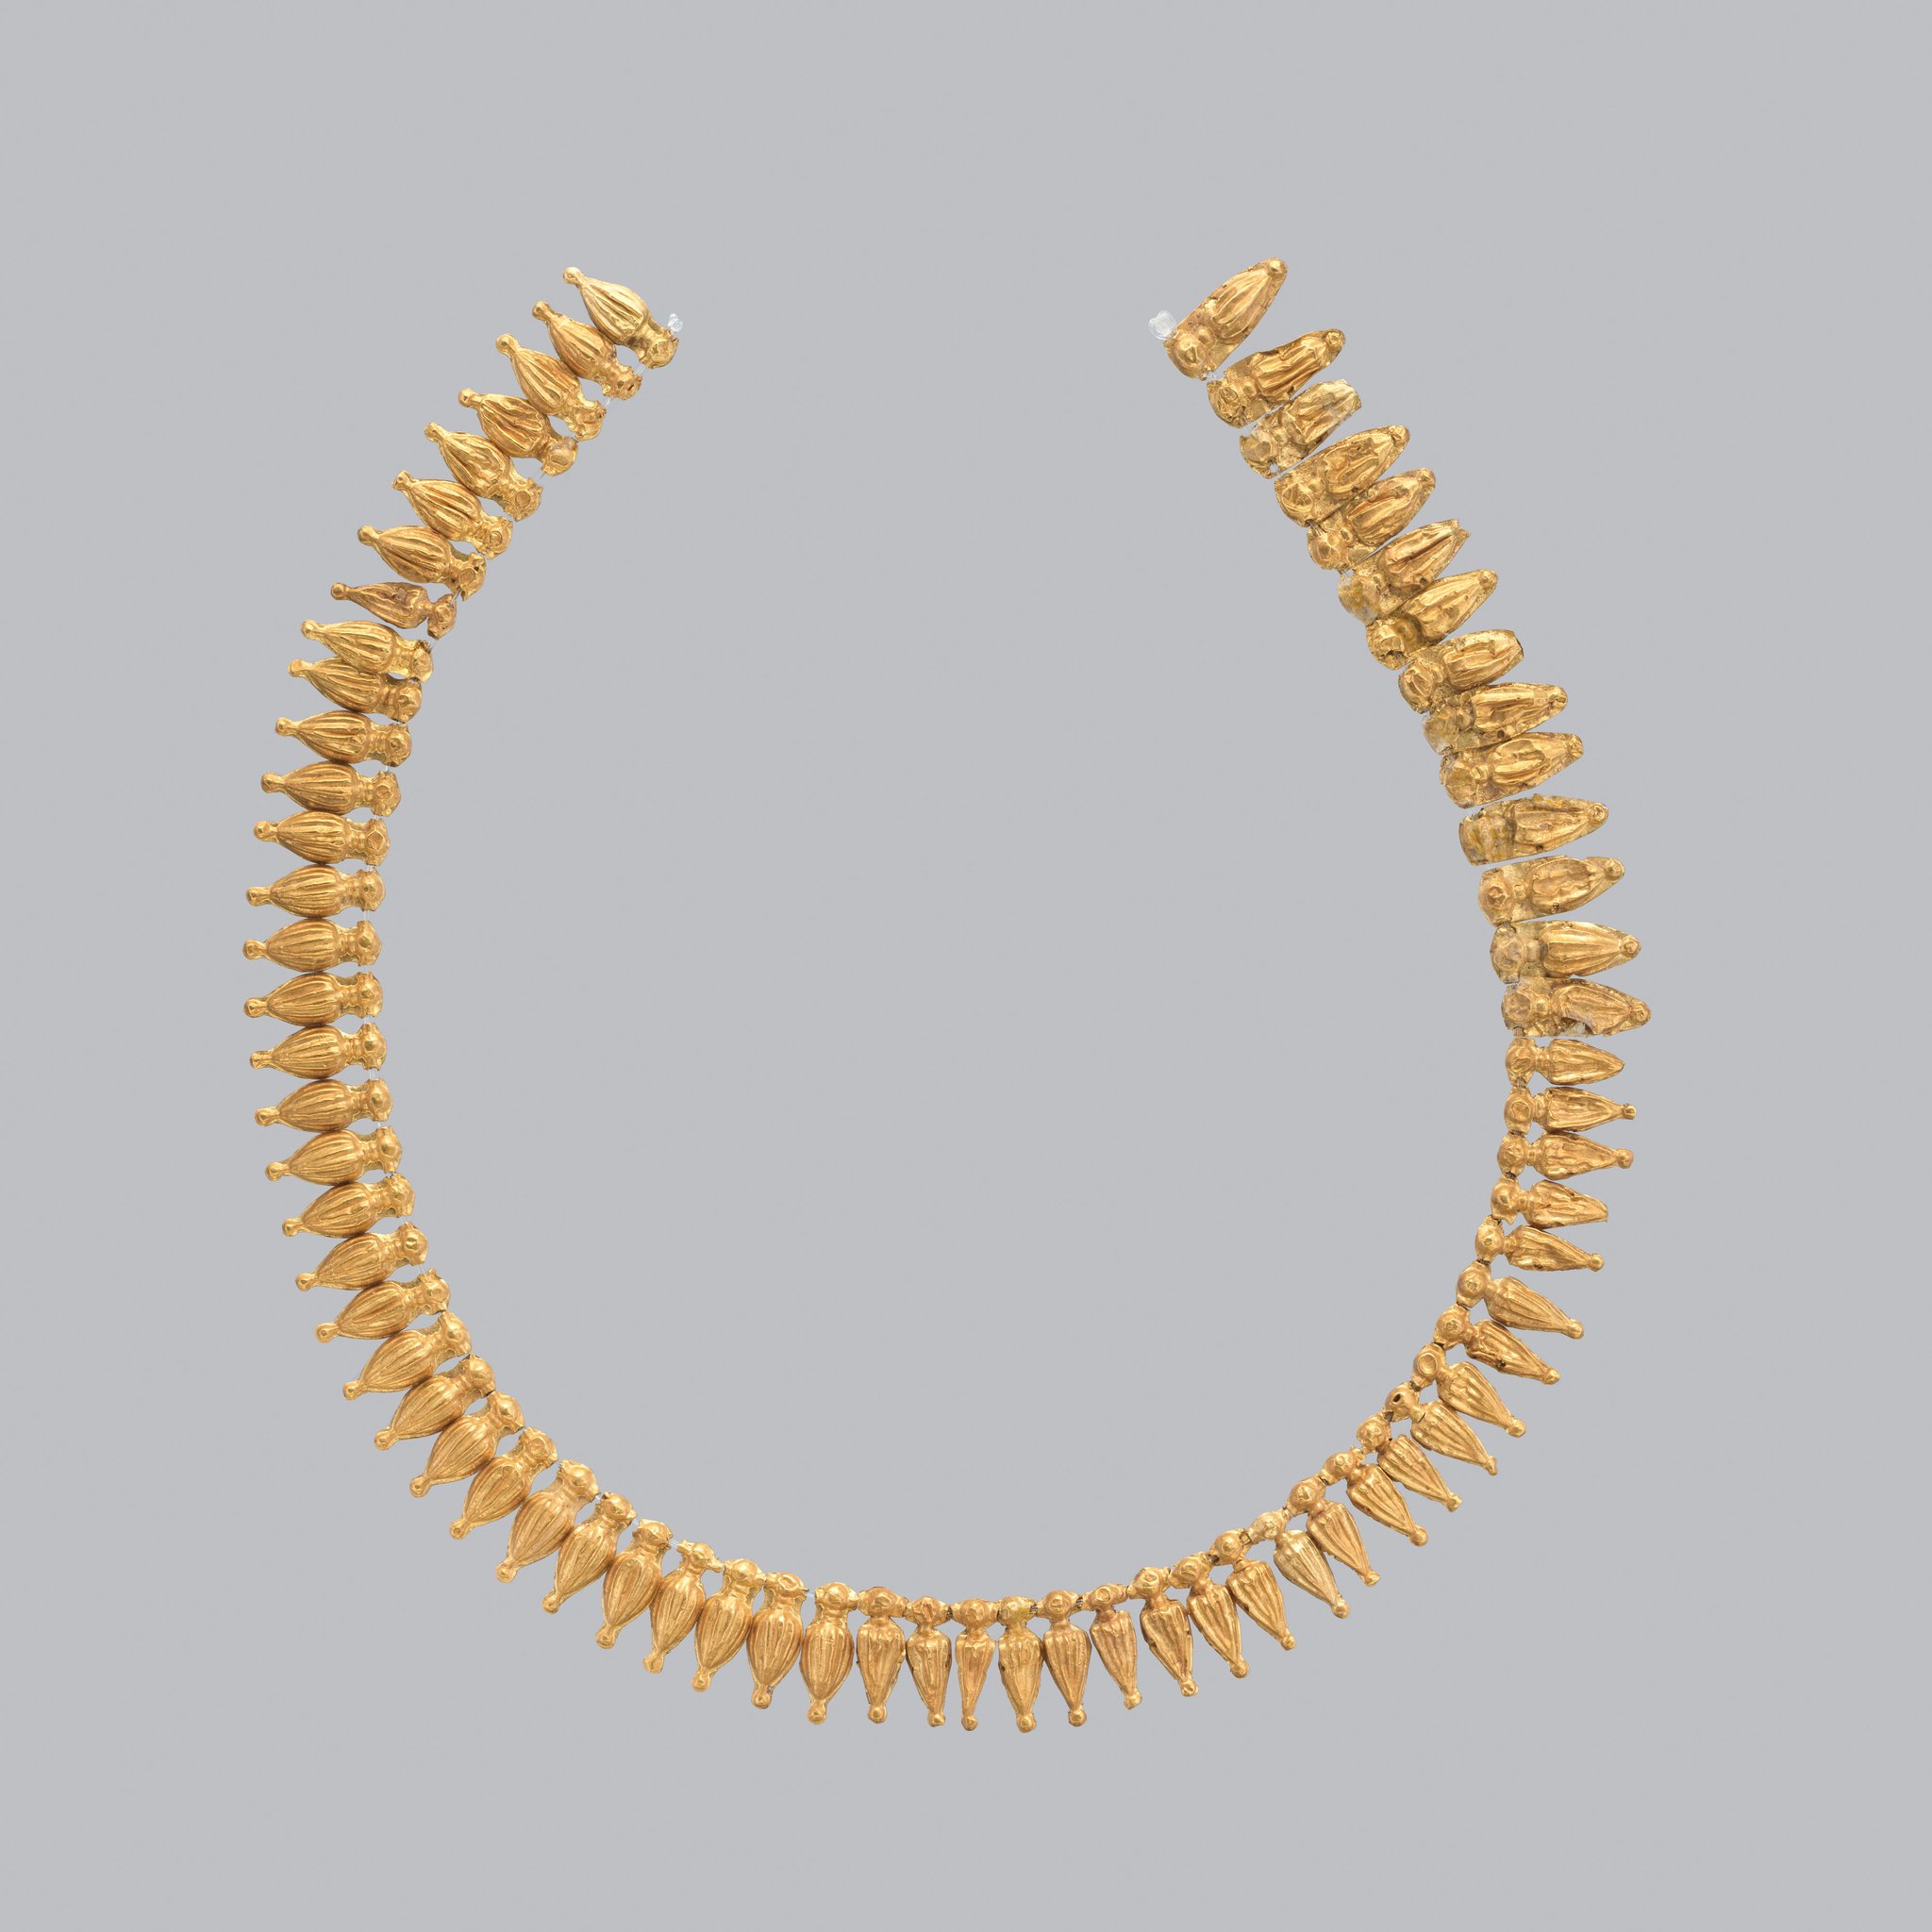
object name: necklace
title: Gold necklace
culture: greek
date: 400-301 BCE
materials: gold